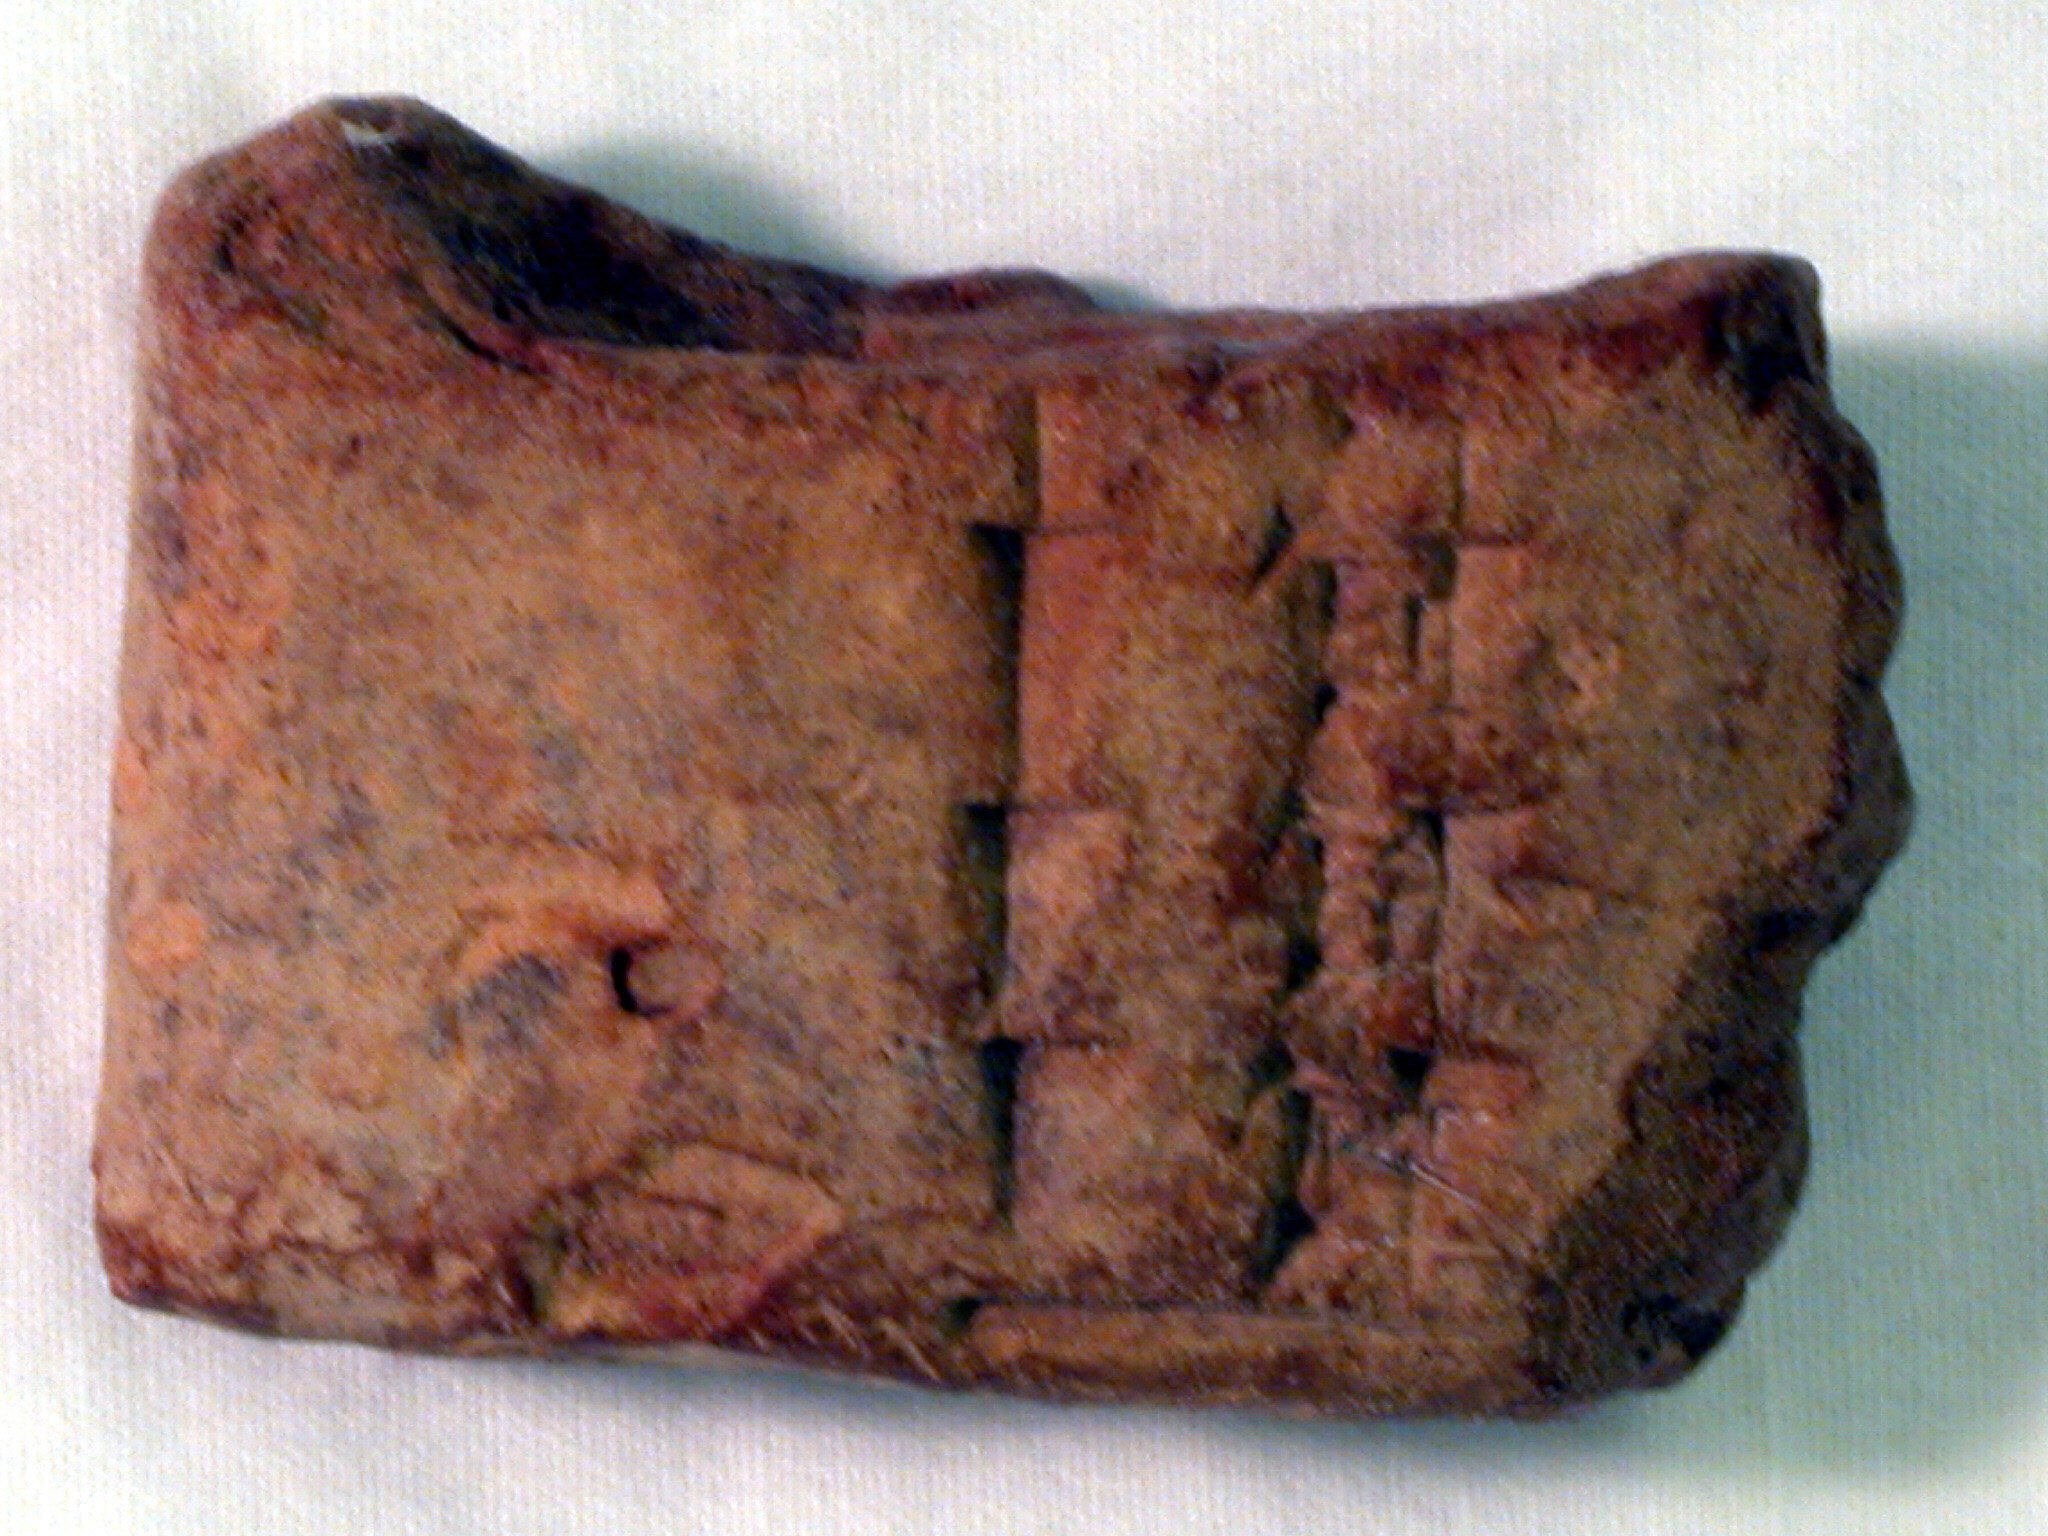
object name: cuneiform tablet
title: Cuneiform tablet: fragment of Syllabary B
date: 333-1 BCE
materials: clay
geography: mesopotamia